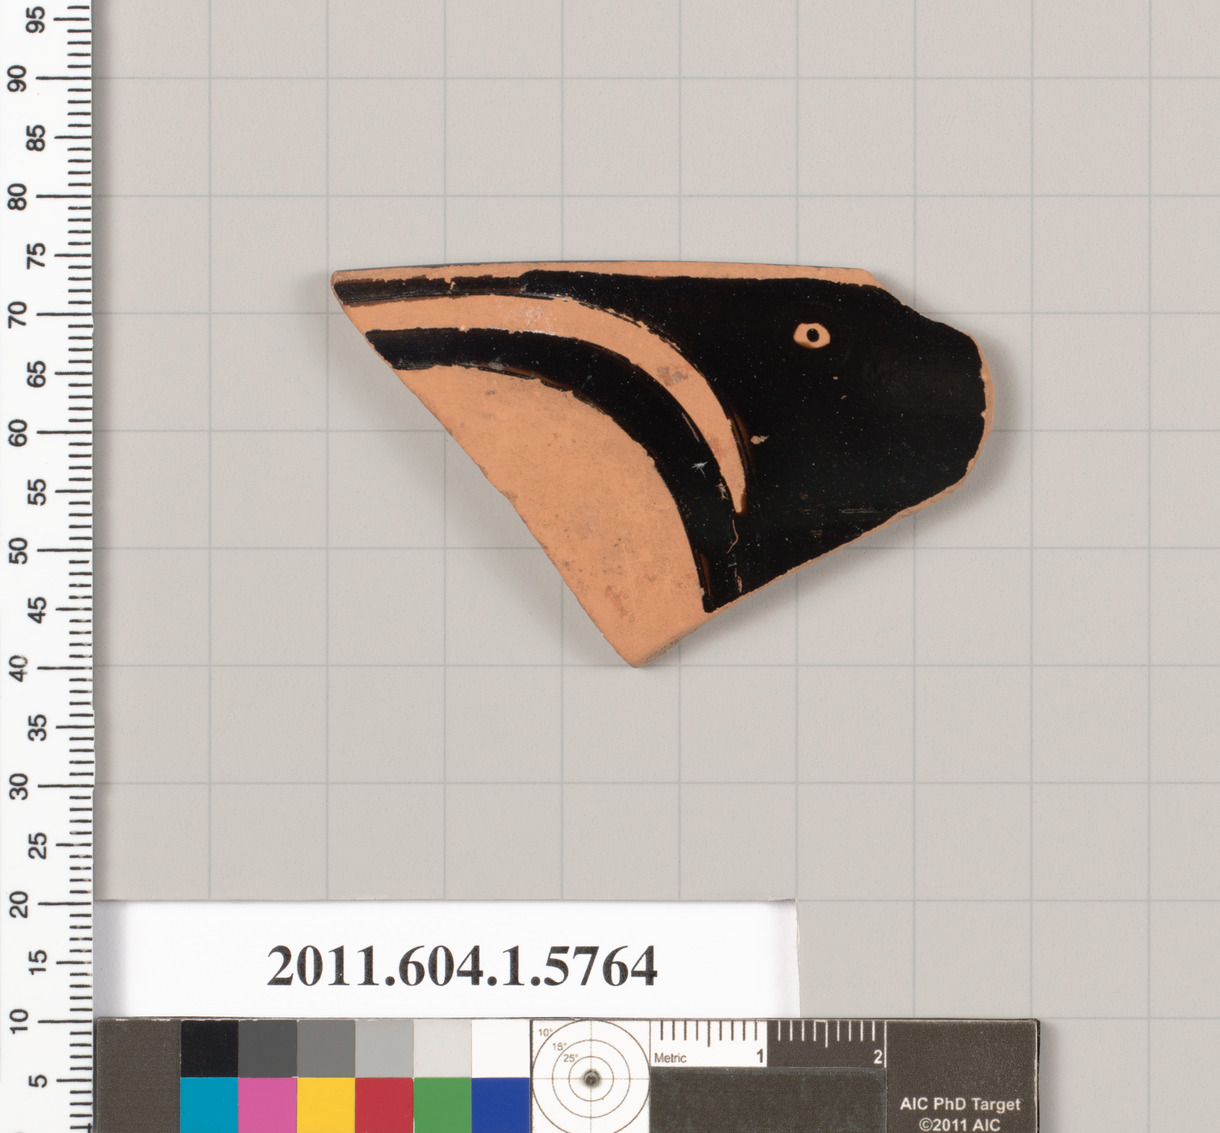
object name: kylix fragment, eye cup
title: Terracotta rim fragment of a kylix: eye-cup (drinking cup)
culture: greek, attic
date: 525-510 BCE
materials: terracotta